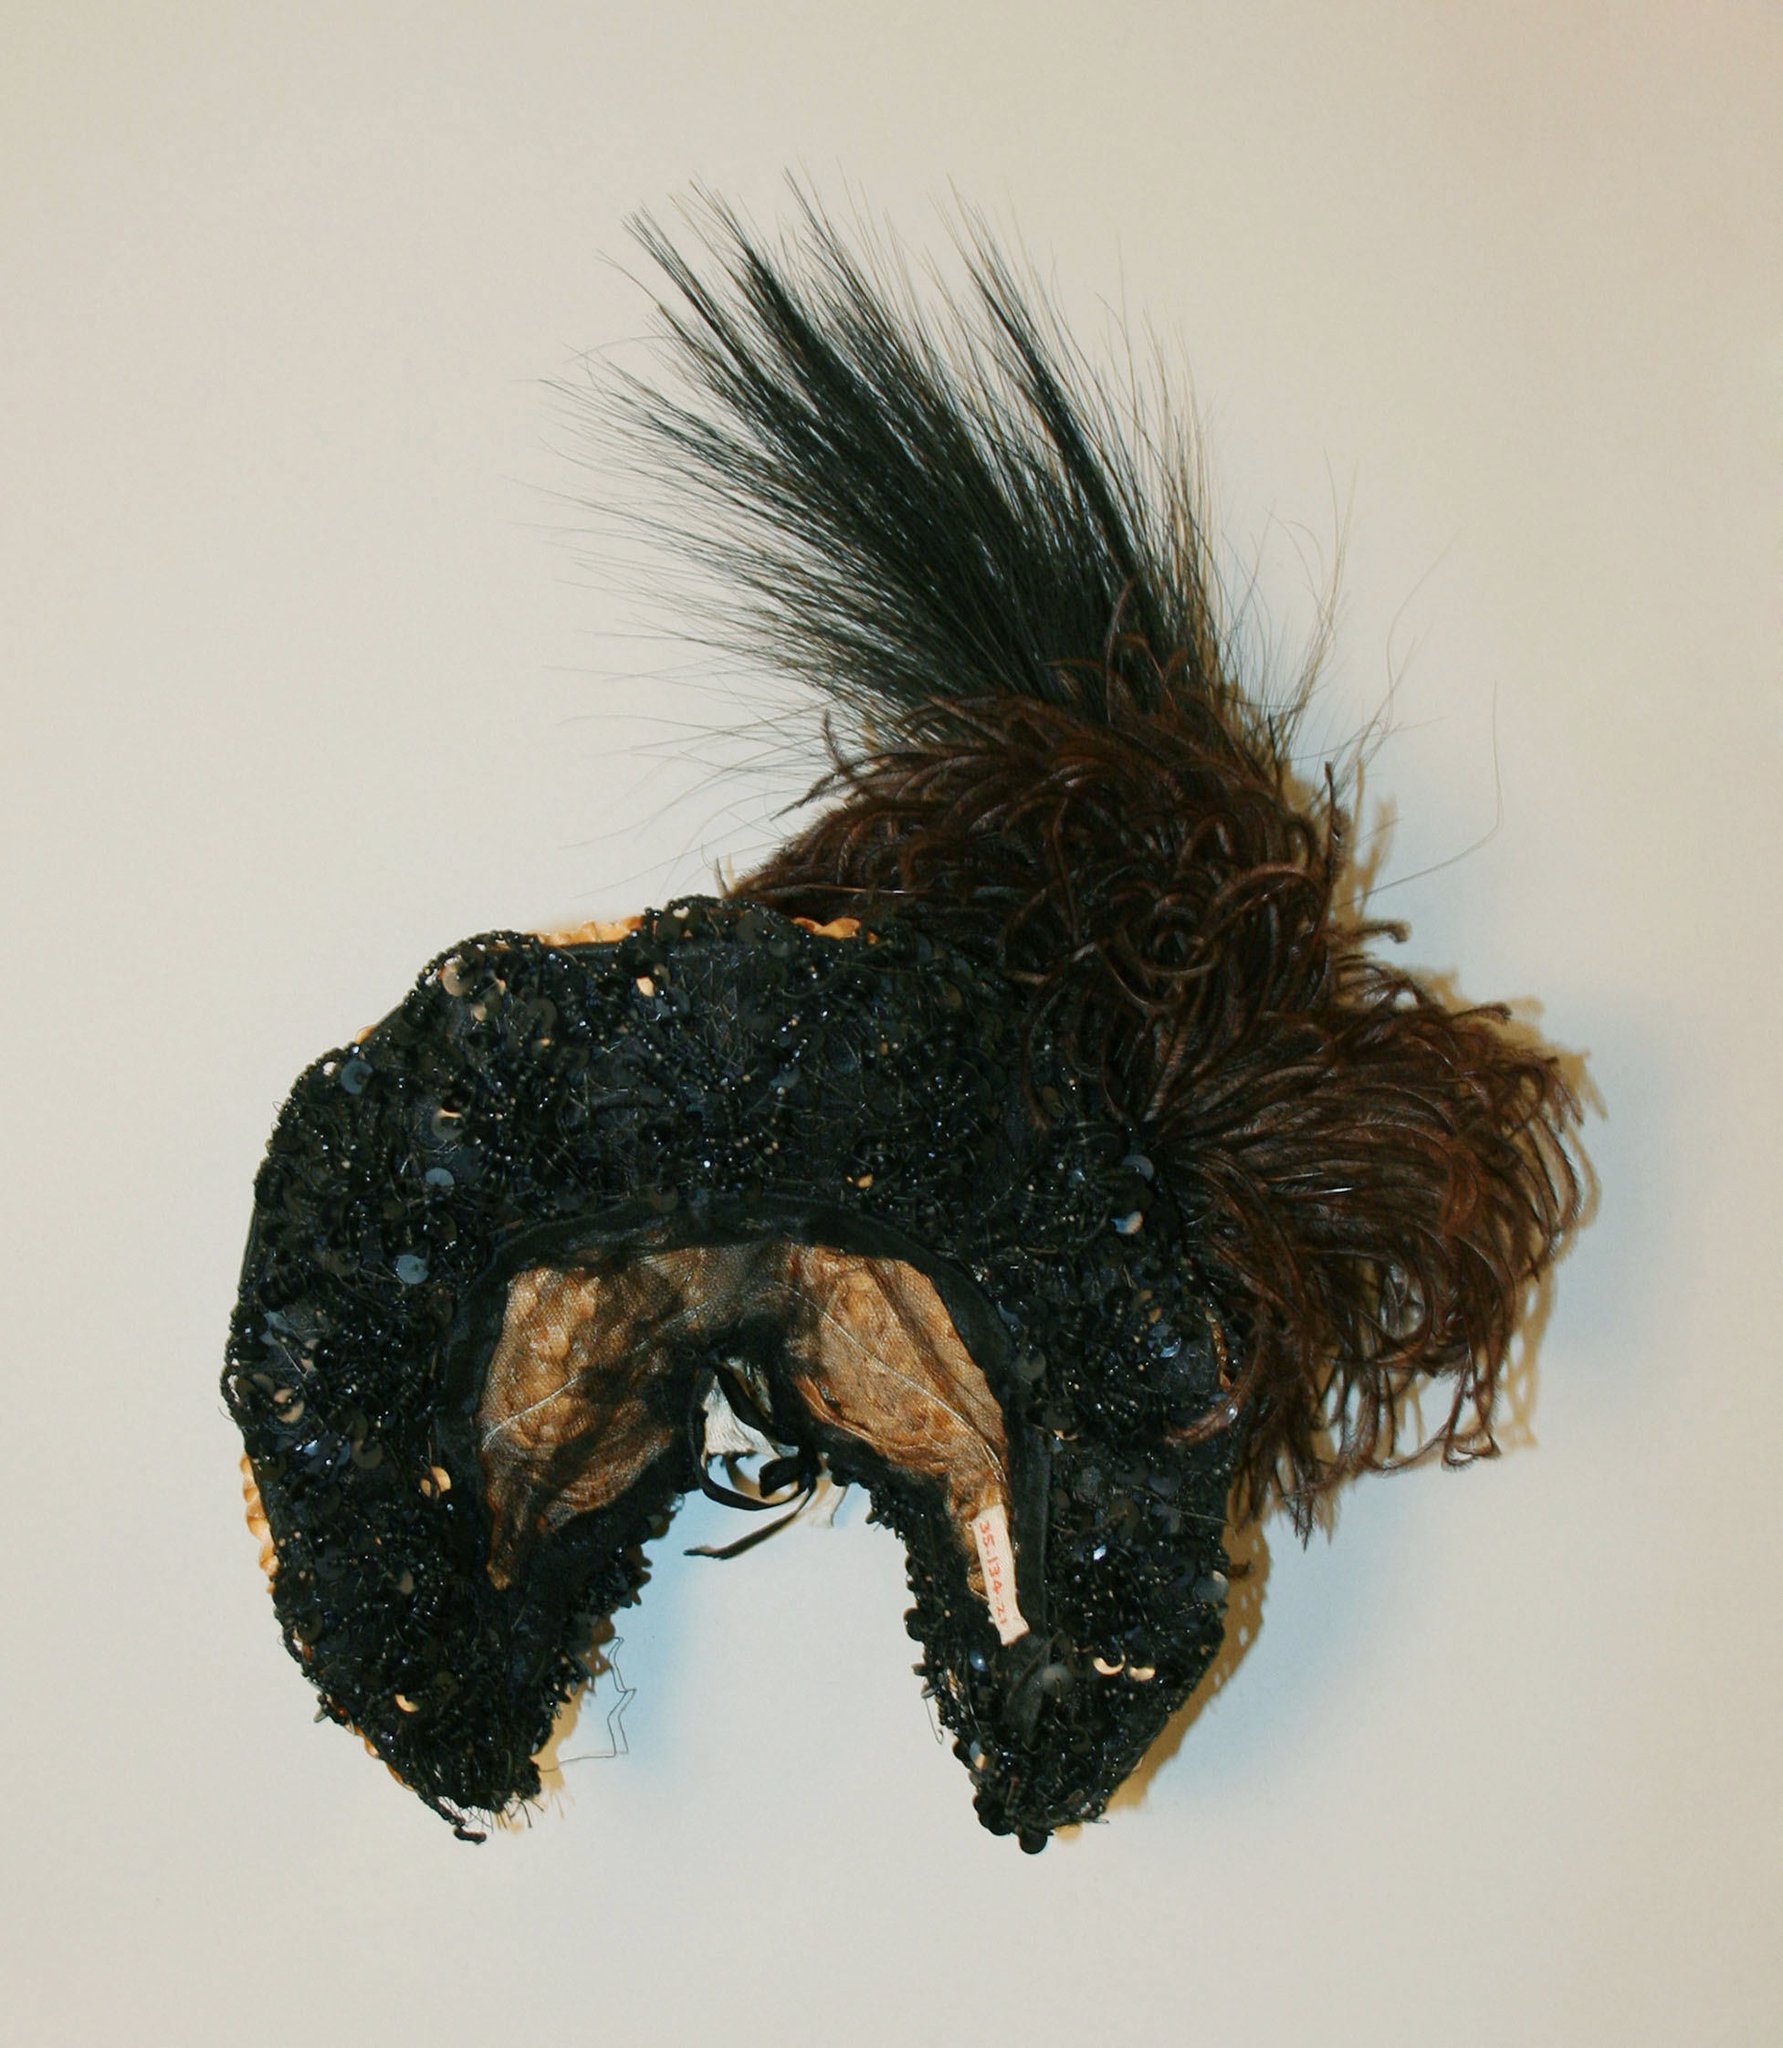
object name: hat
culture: american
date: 1895-1896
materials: feather, fiber